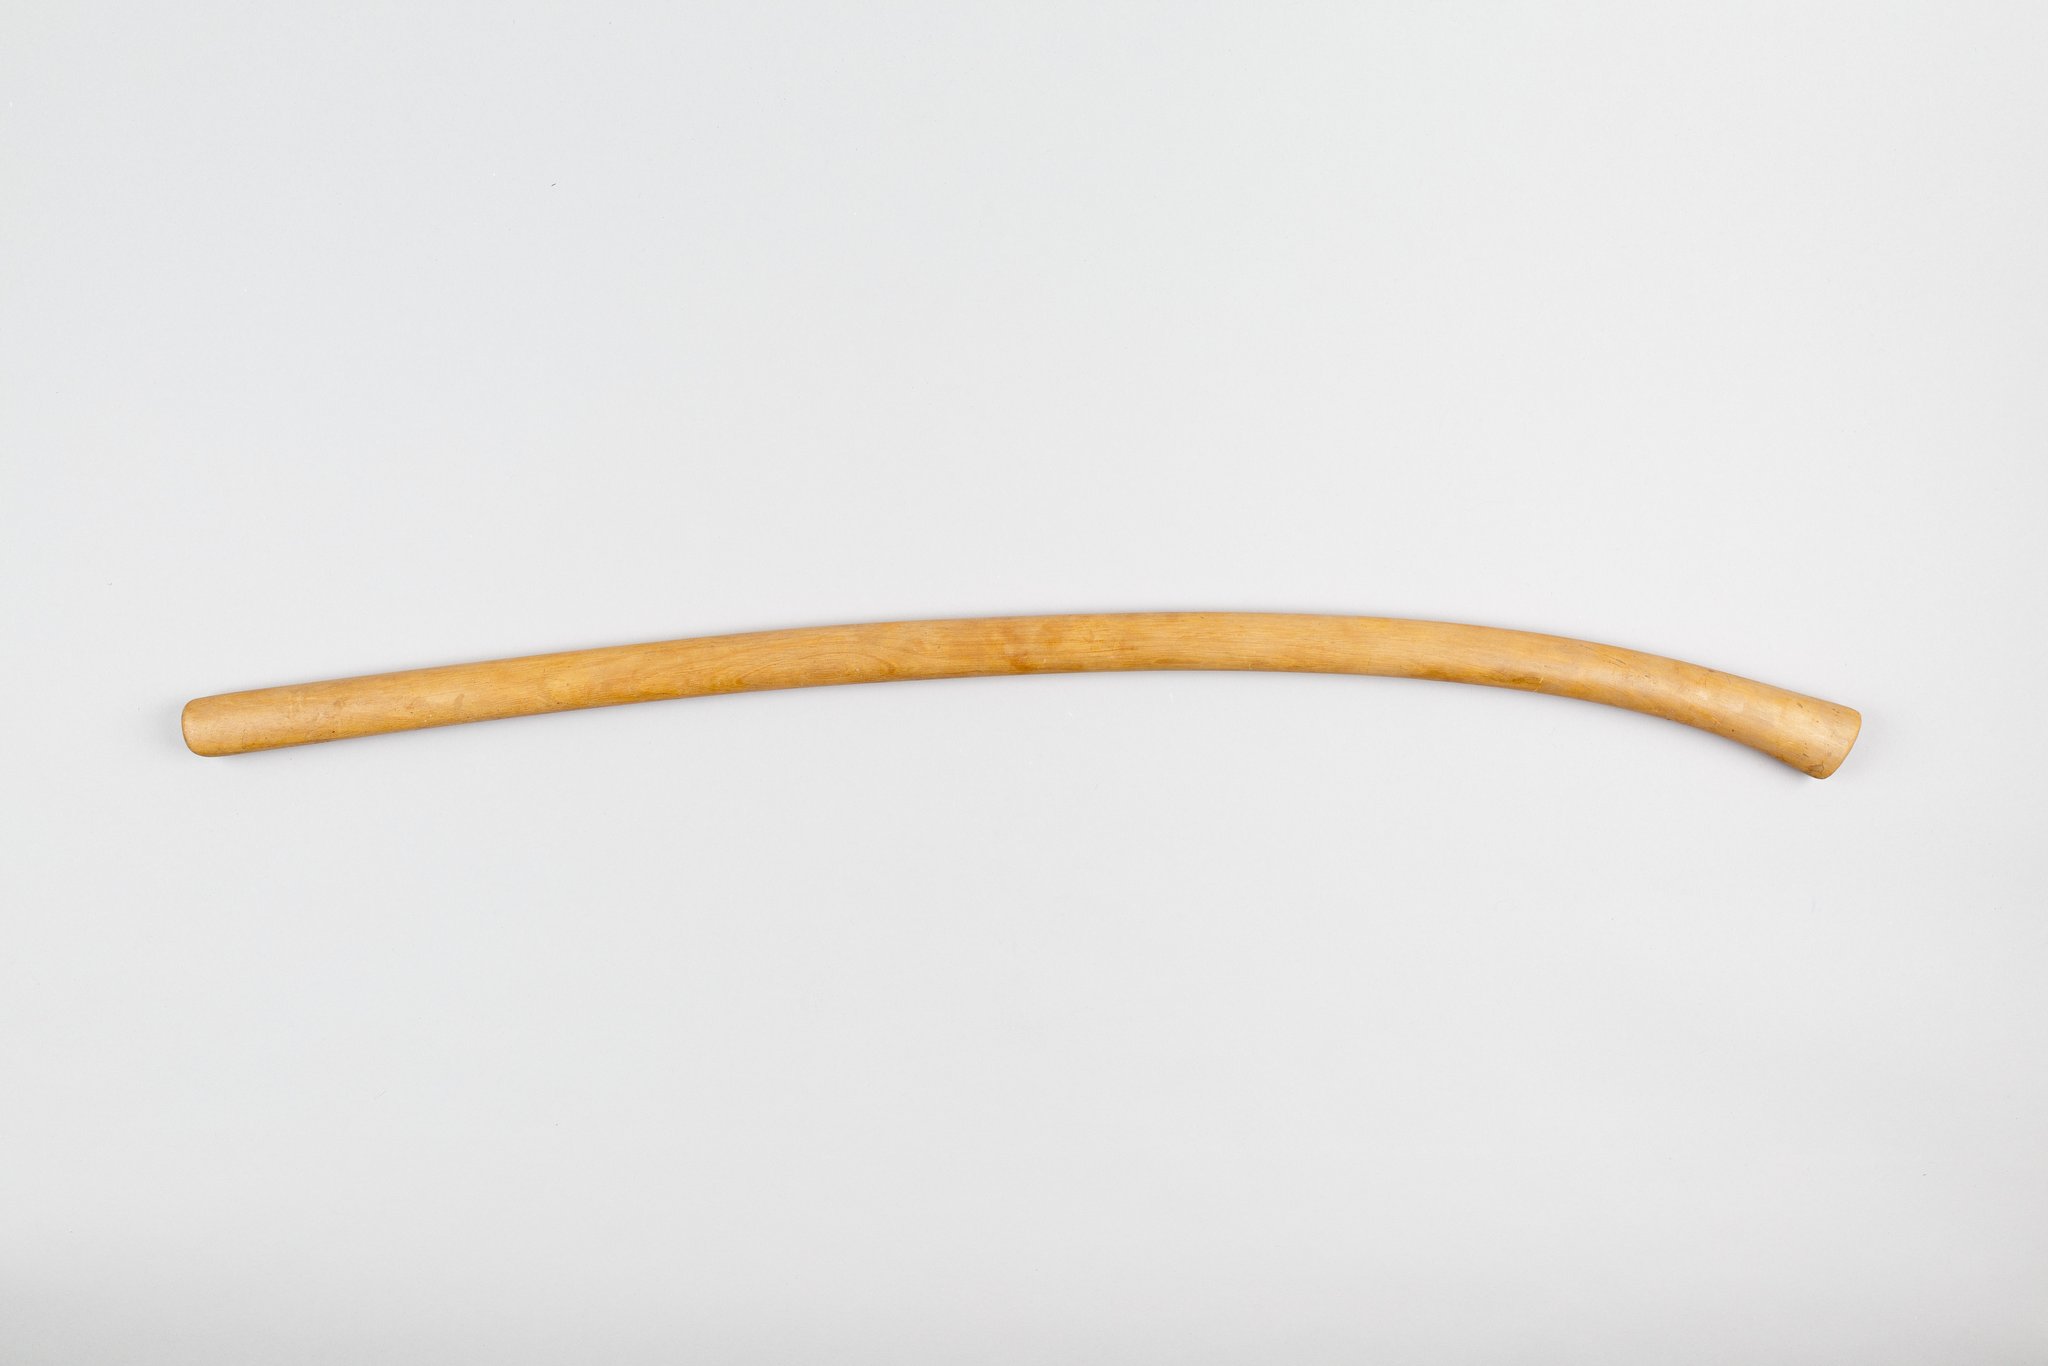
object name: club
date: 1479-1458 BCE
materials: wood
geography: egypt